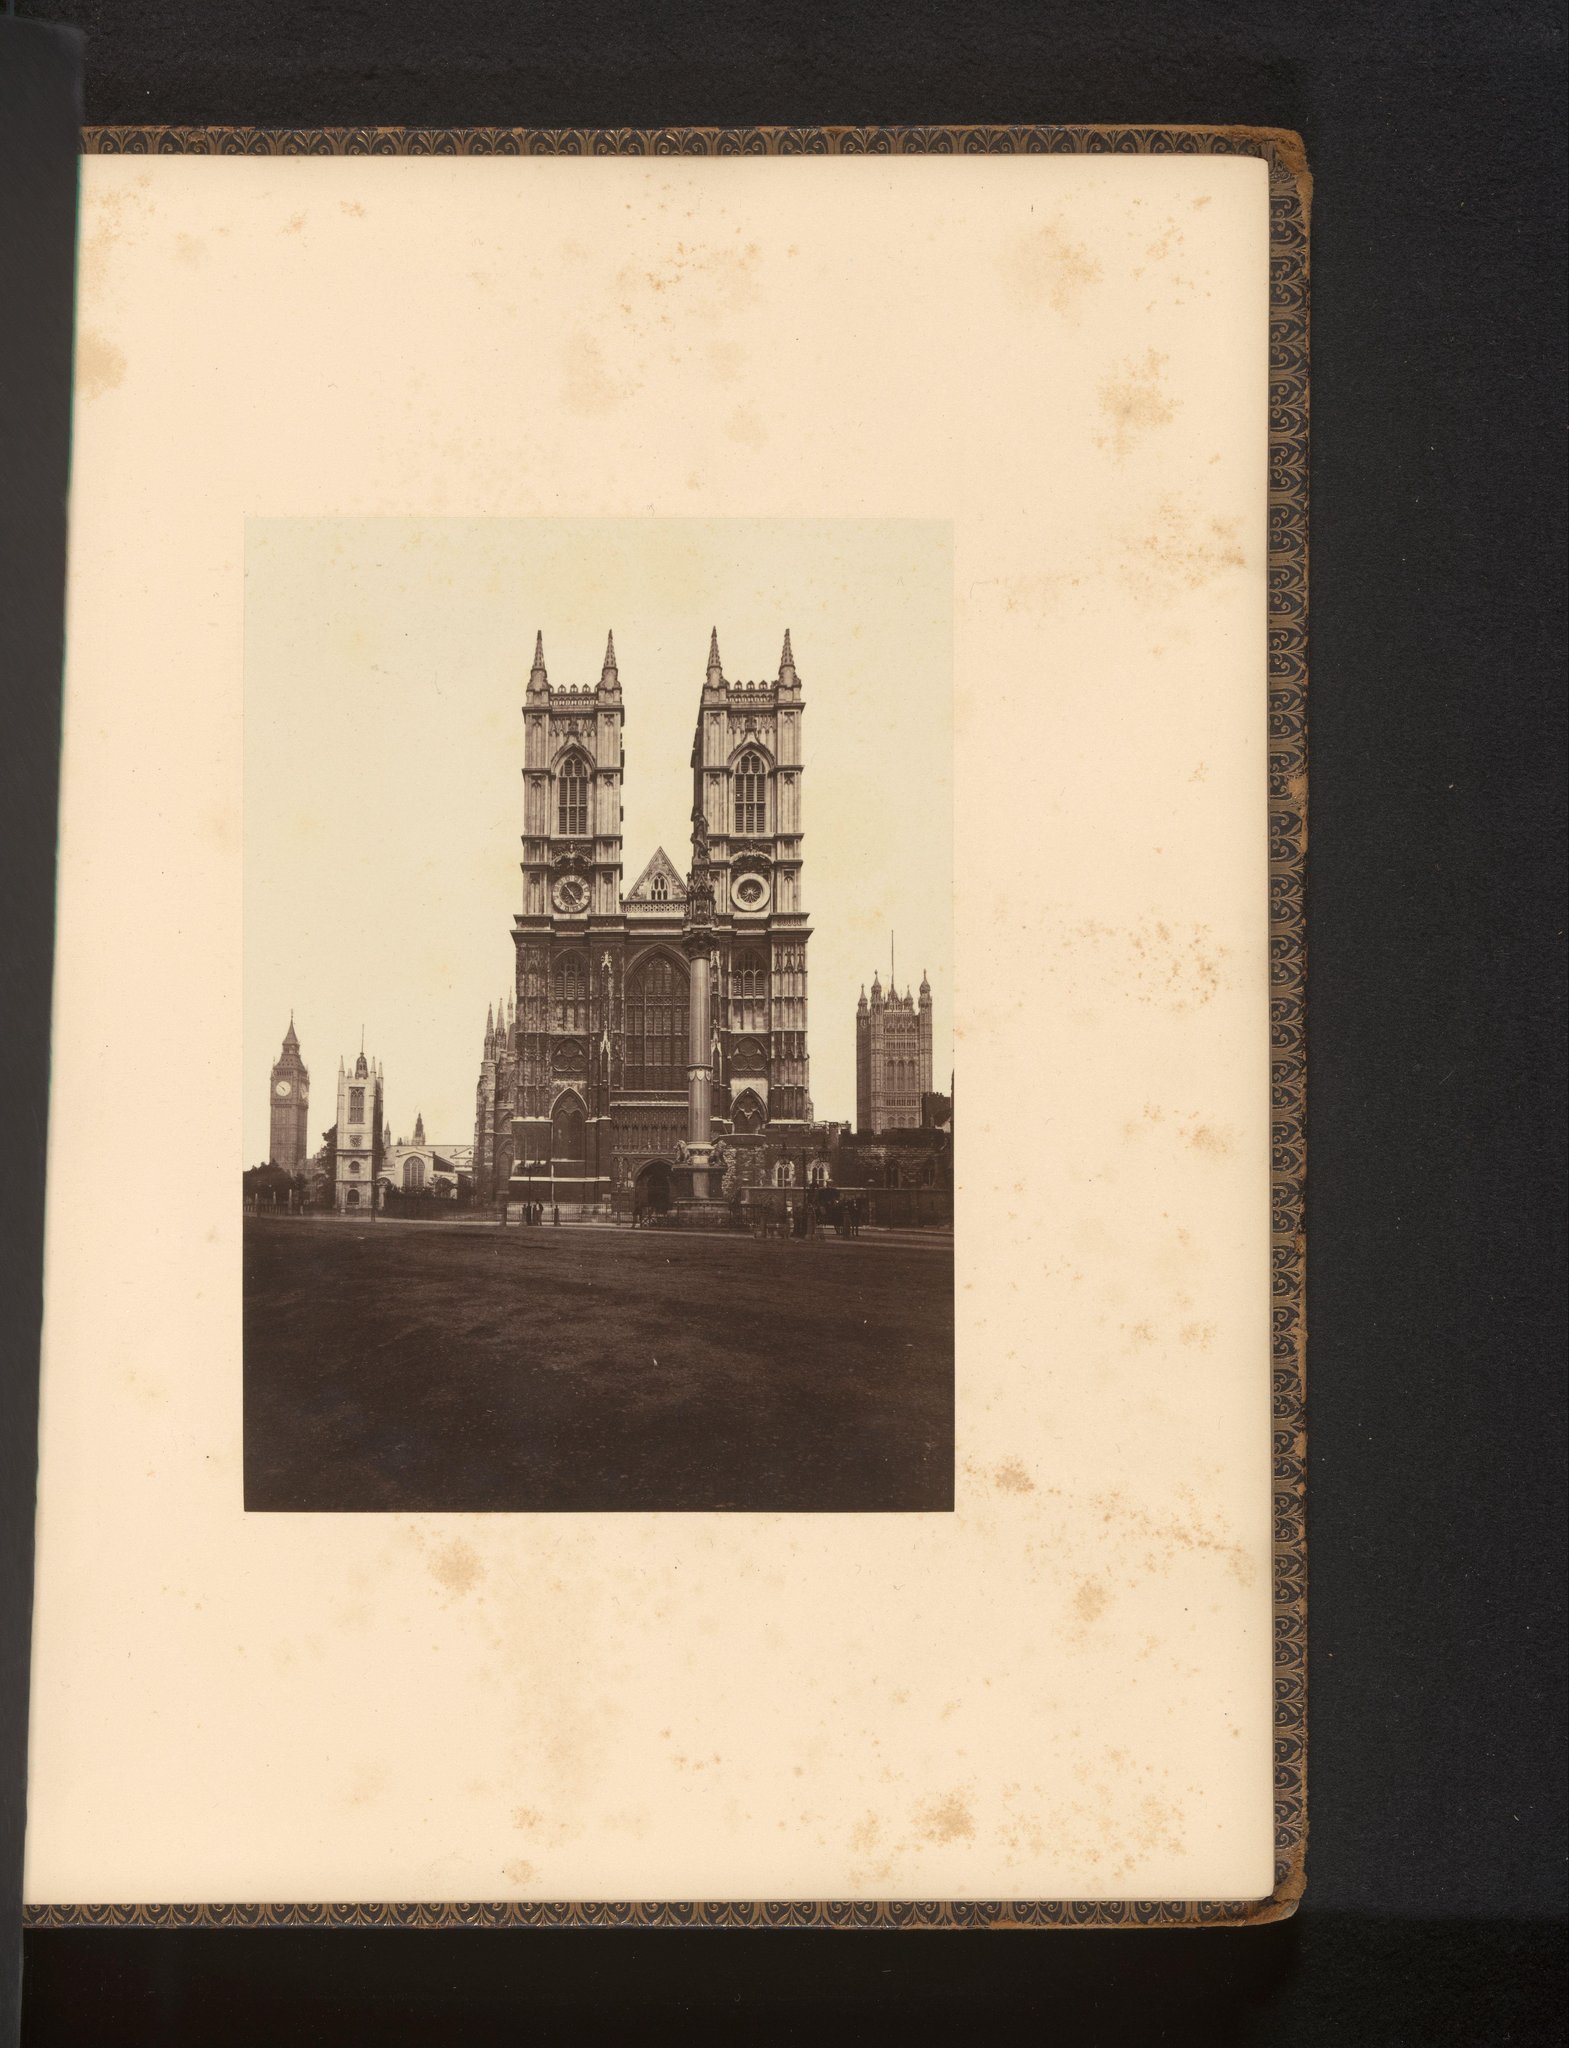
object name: photograph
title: Gezicht op Westminster Abbey, de westelijke kant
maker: john harrington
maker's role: fotograaf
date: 1864-1869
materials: photographic support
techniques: albumen print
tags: front façade, westminster abbey